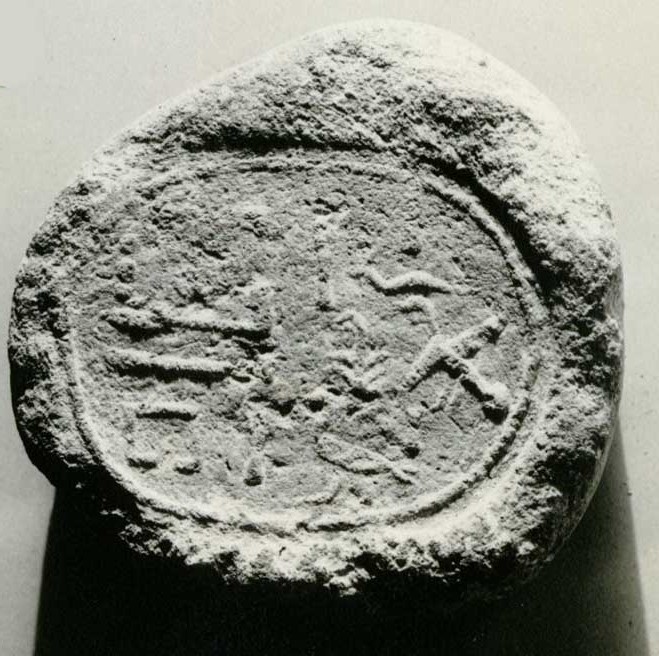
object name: cone, pasinesu, chief of servant, royal palace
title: Funerary Cone of Chief of Servants of the Royal Palace Pasinesu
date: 1550-1295 BCE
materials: pottery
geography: egypt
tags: hieroglyphs